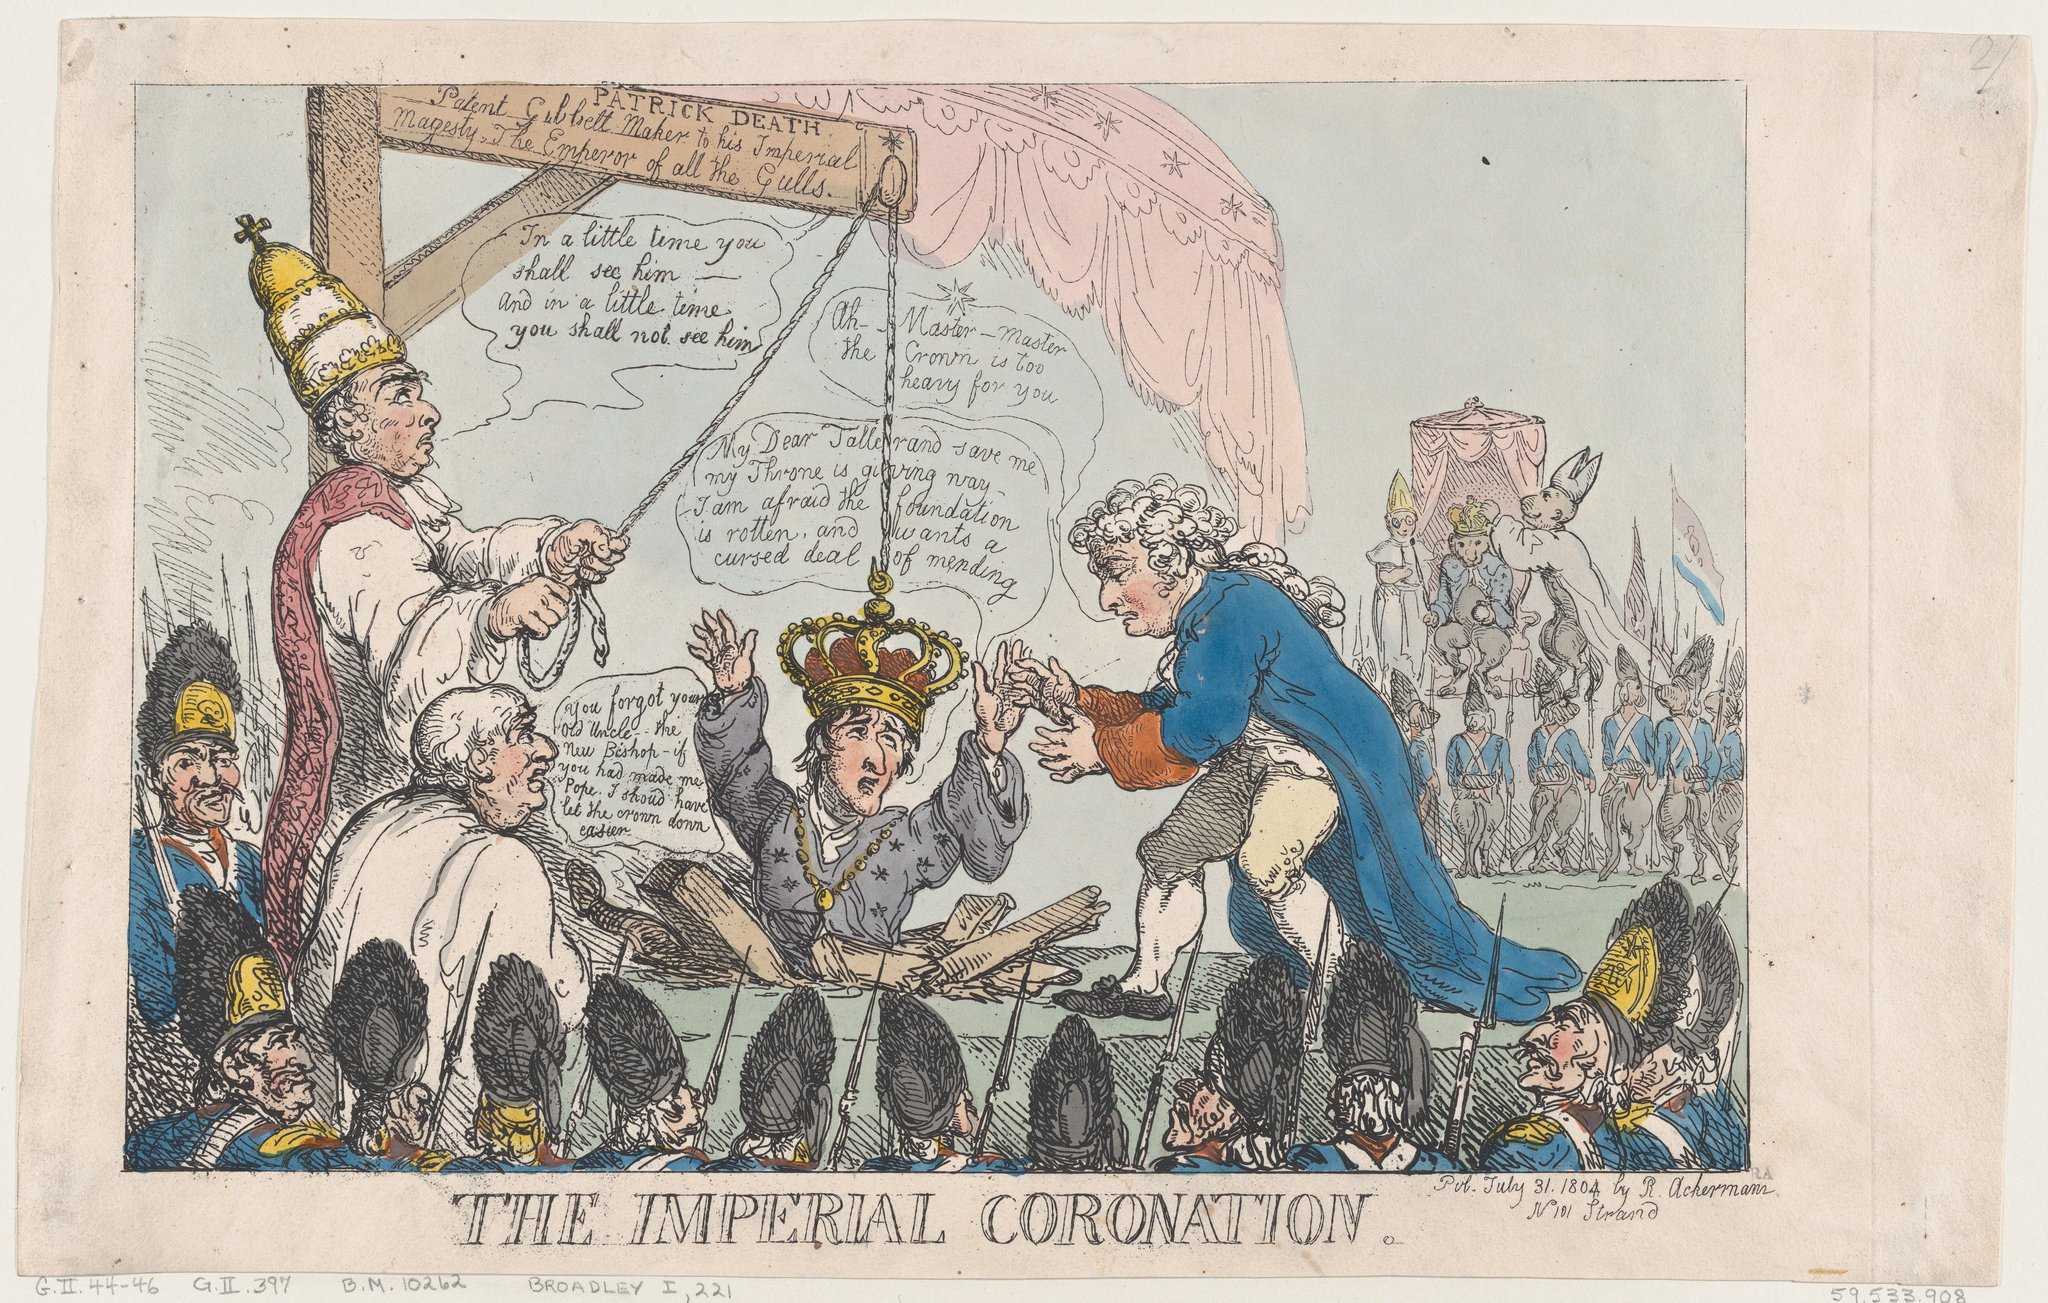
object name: print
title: The Imperial Coronation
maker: thomas rowlandson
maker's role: artist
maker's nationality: british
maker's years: 1757-1827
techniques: etching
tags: satire,napoleon i,men,politics